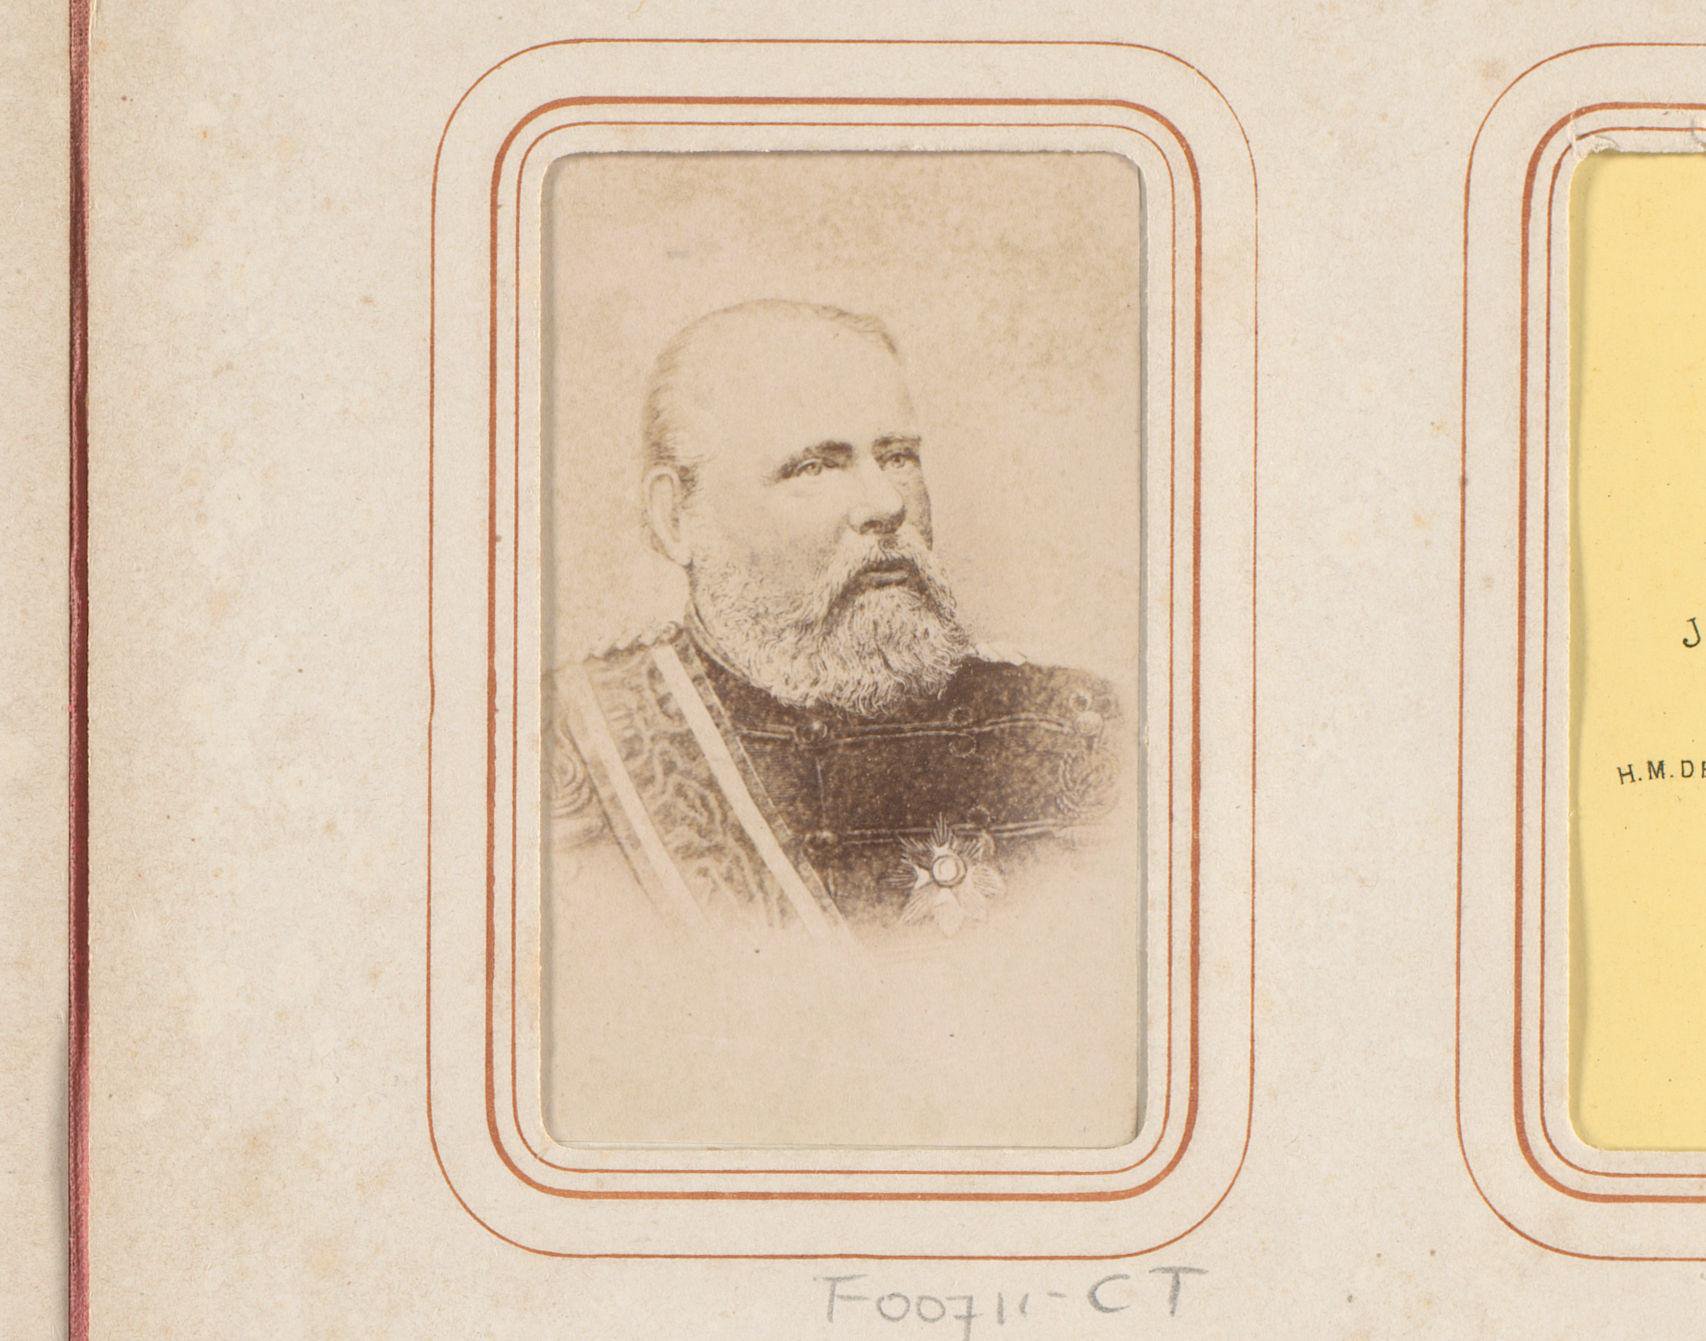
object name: carte de visite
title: Fotoreproductie van een tekening van een portret van een koning van Nederland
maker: Anonymous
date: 1860-1890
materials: cardboard, photographic support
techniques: albumen print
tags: historical persons, king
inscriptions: inscription: ‘S.M. le roi des Pays-Bas.’